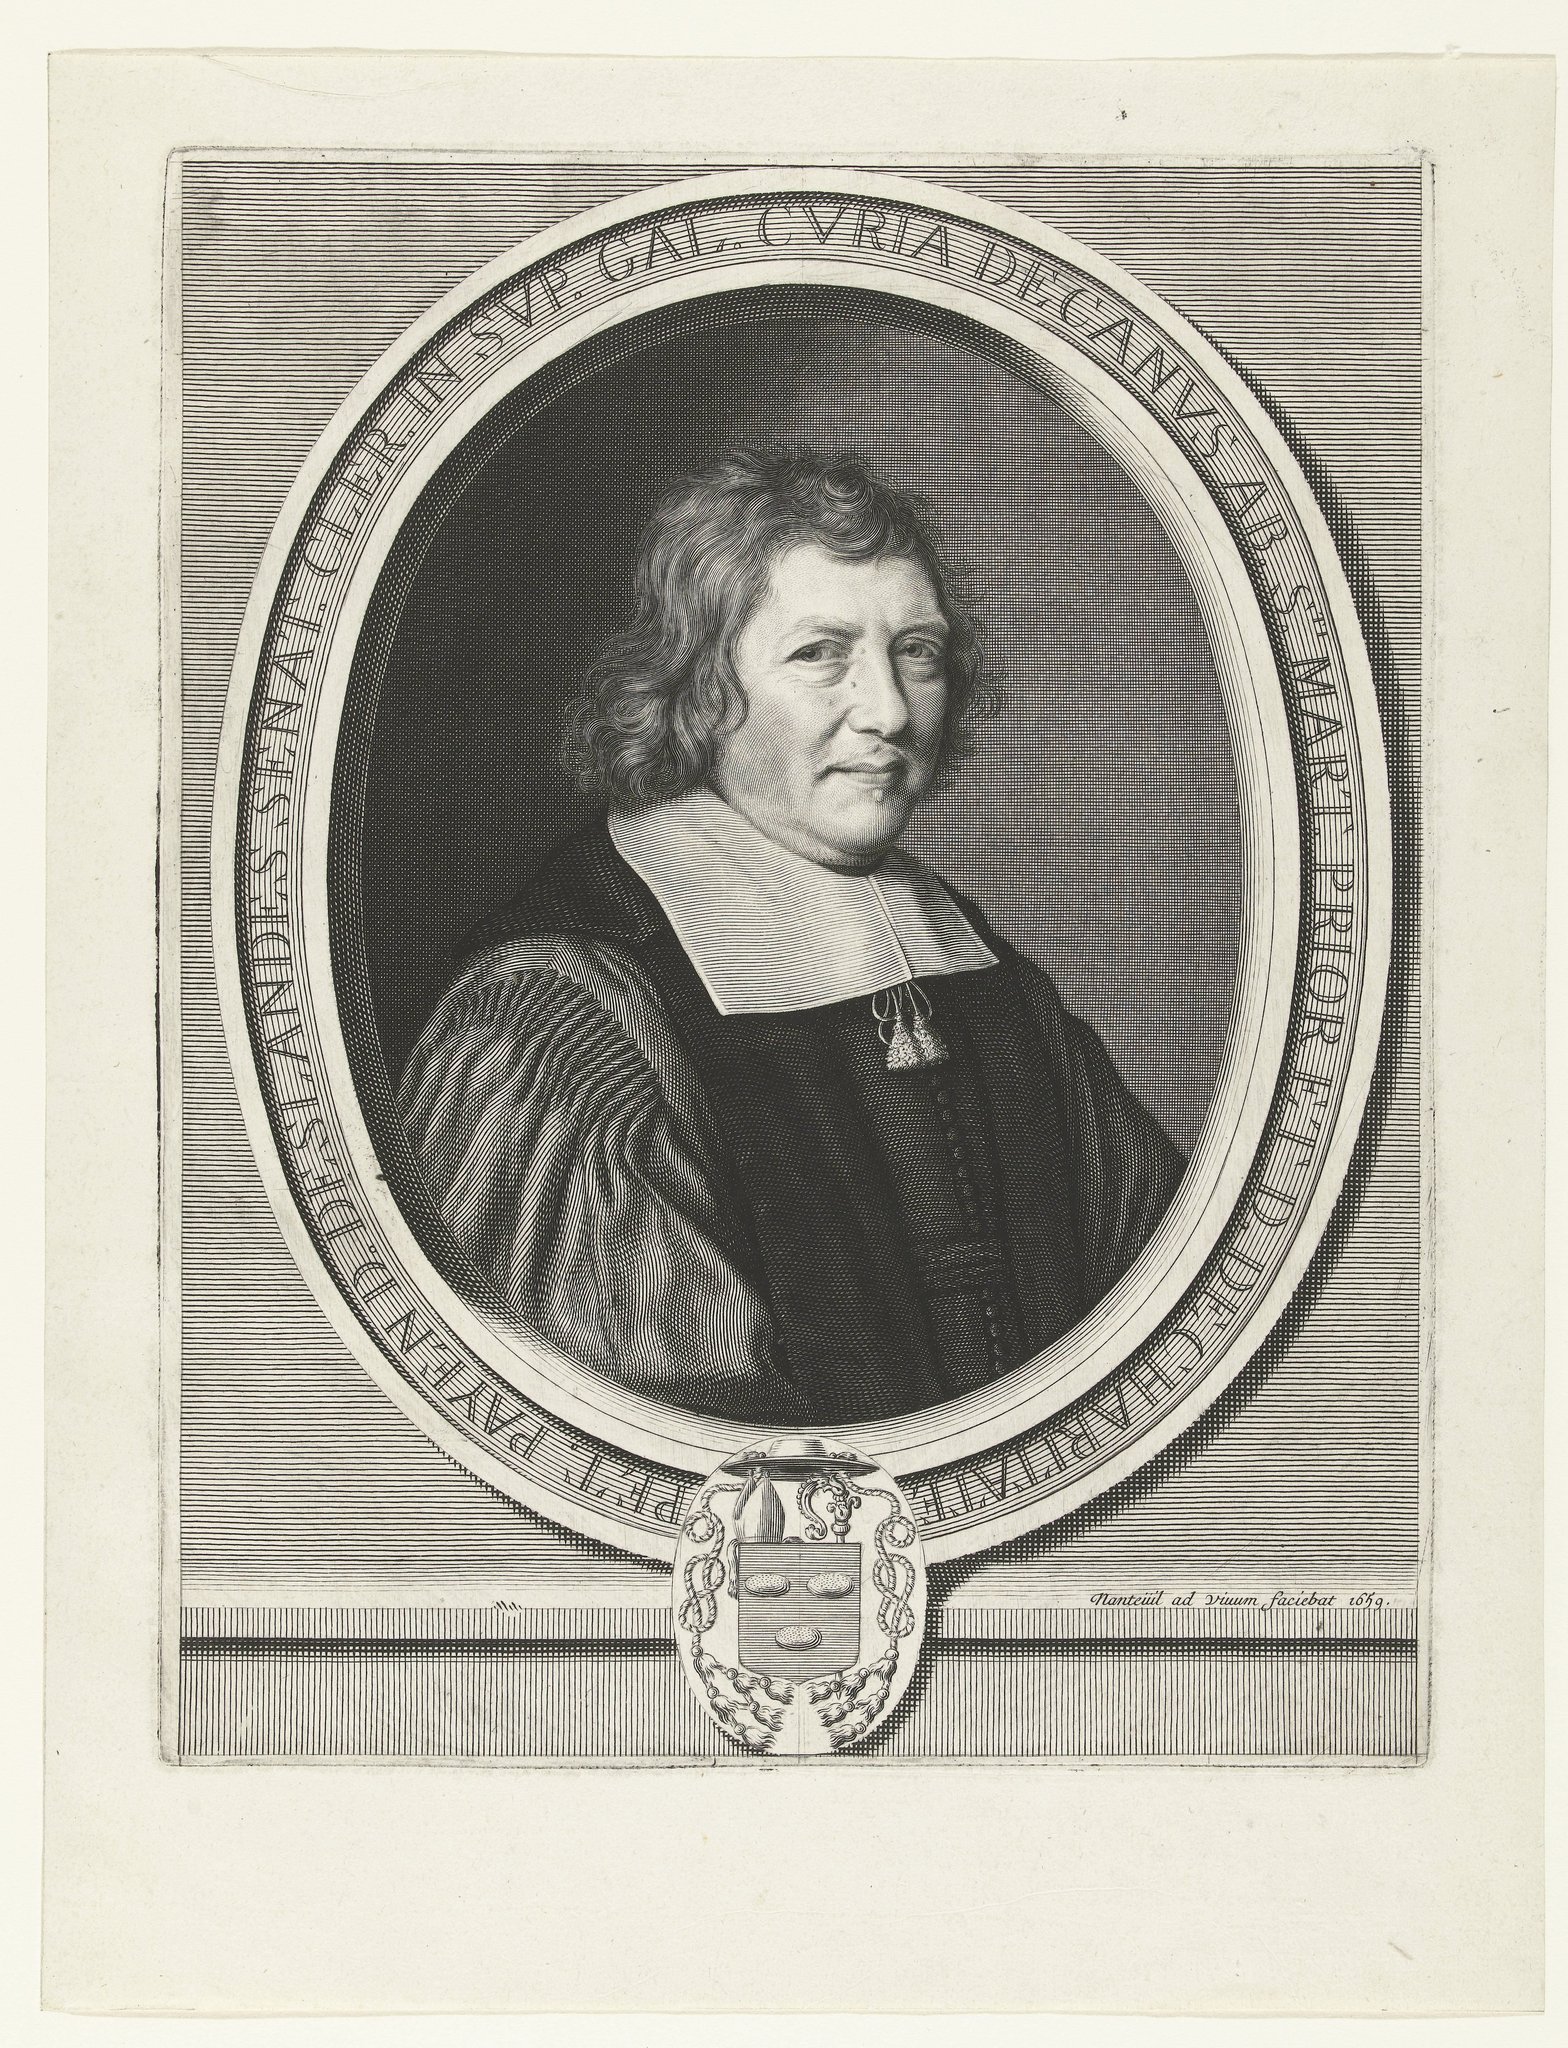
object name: print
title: Pet. payen D. Deslandes senat. cler. in sup. cal. curia decanus ab. s.ti mart. prior et D. de charitate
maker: robert nanteuil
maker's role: print maker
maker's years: 1623-1678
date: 1659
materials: paper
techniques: engraving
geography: france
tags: paris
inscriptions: collector's mark: Lugt 240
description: Portret van de staatsman Pierre Payen, in een ovale omlijsting met tekst. Onderaan een wapenschild.